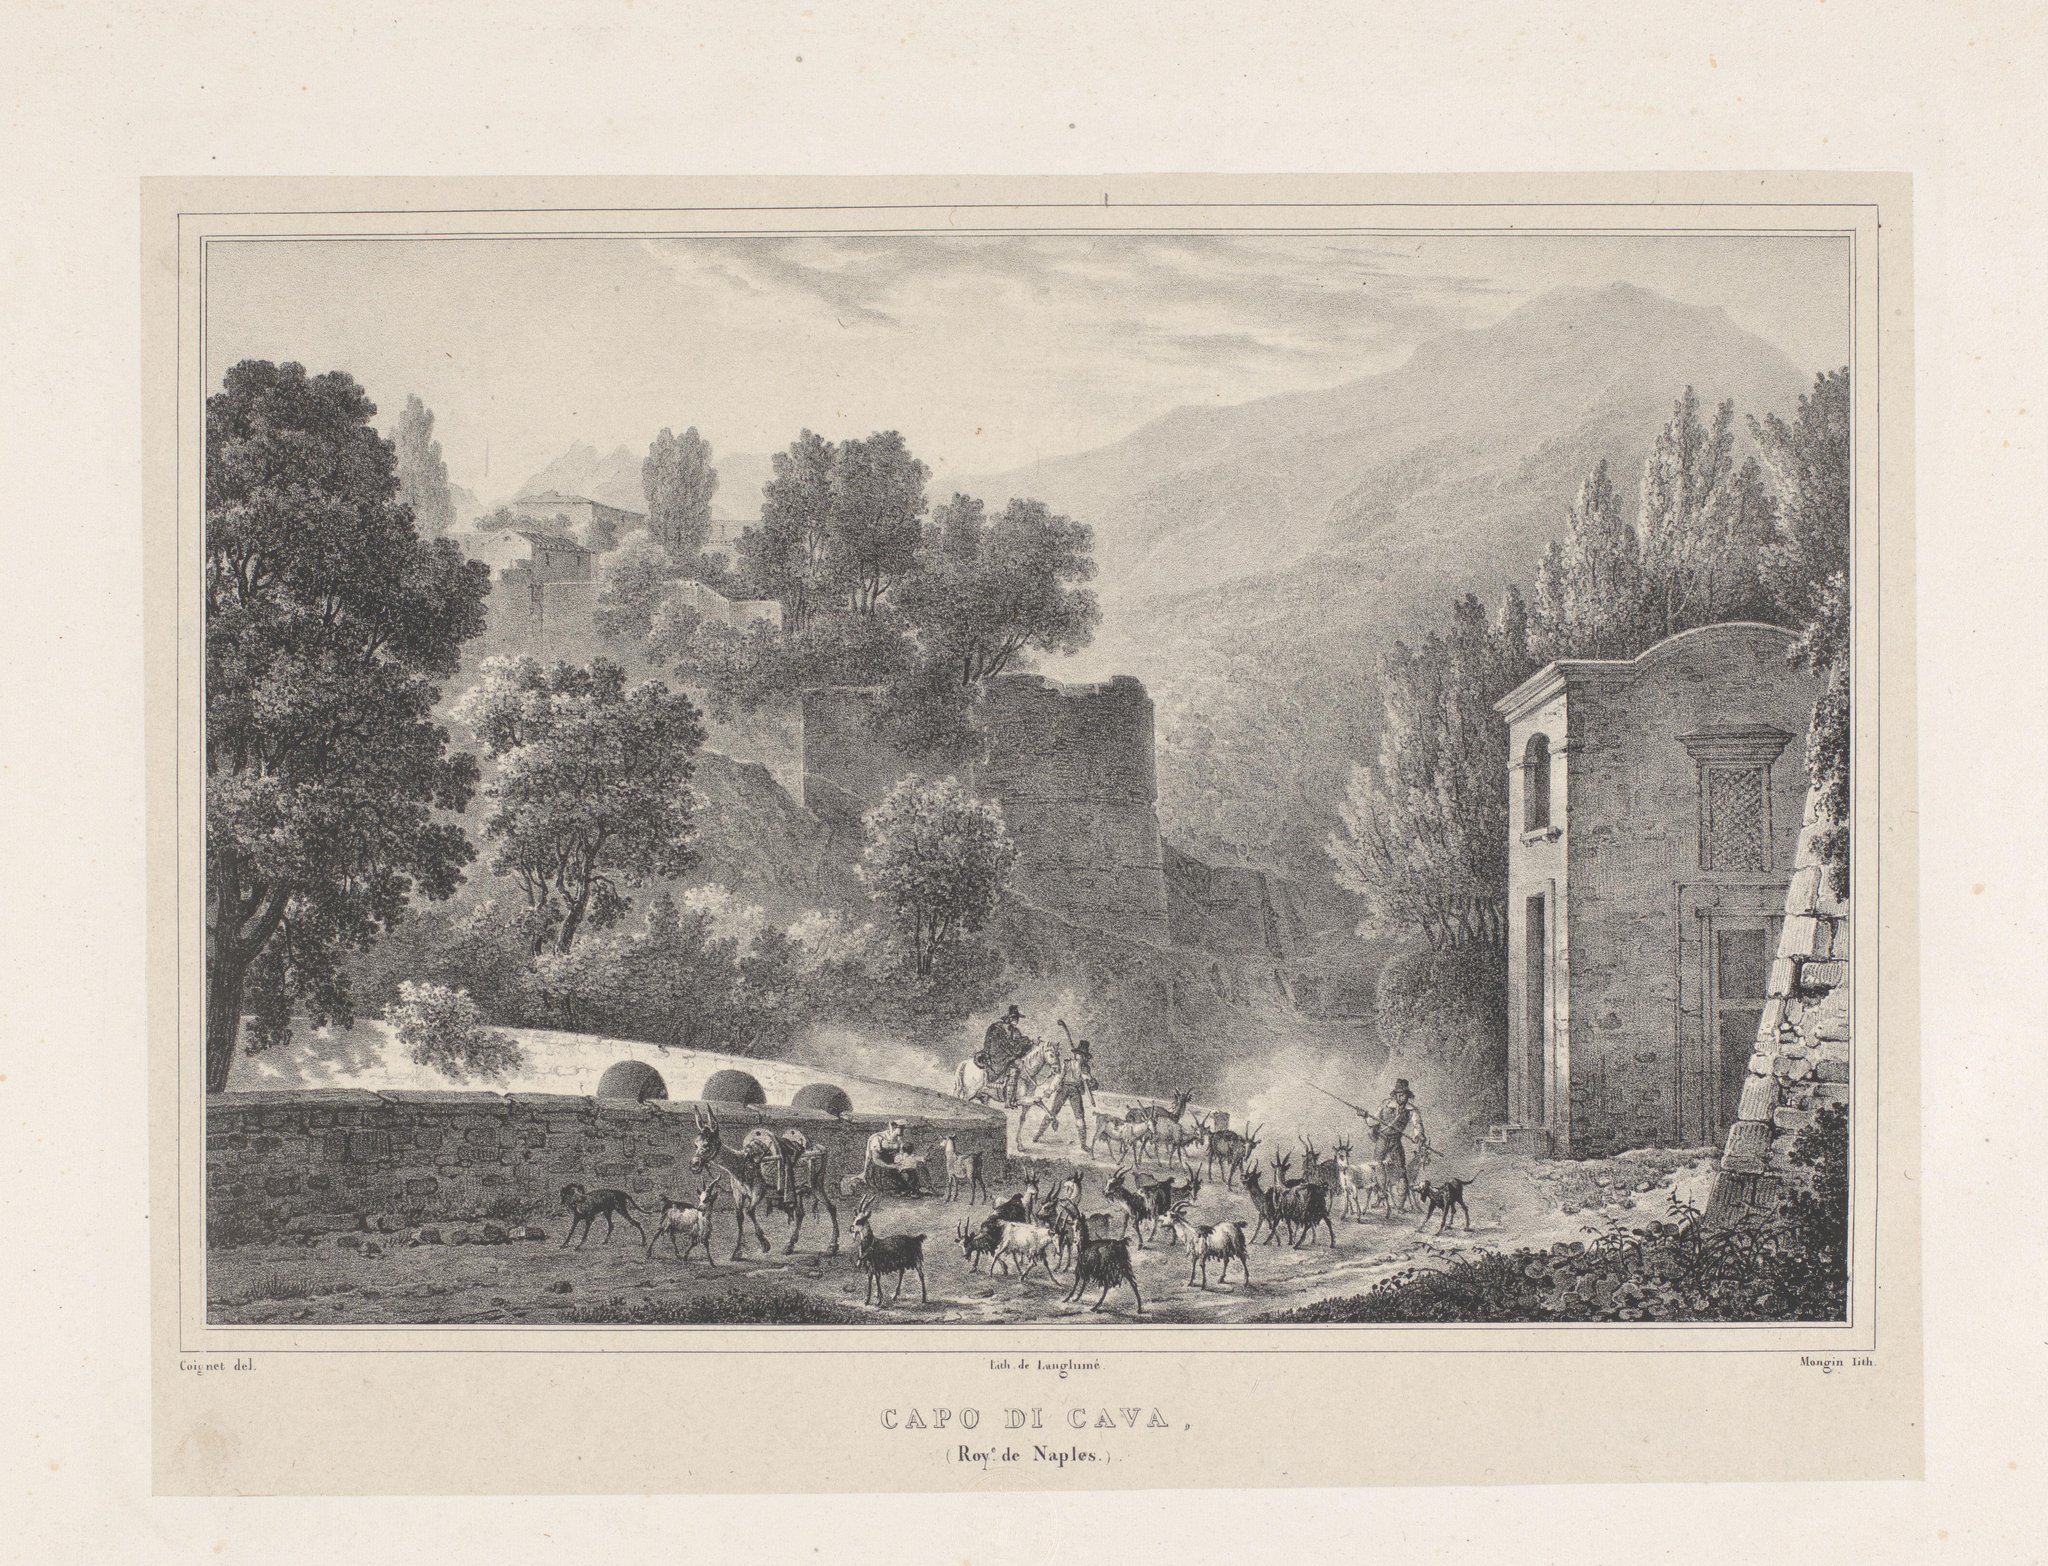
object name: print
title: Gezichten in Italië naar tekeningen van Jules Coignet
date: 1824-1826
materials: paper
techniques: lithograph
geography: paris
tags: herding, herdsman, herdswoman, shepherd, shepherdess, cowherd, etc., landscape with bridge, viaduct or aqueduct, outskirts of village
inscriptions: check stamp: Lugt 3431, collector's mark: Lugt 2228, watermark: ‘Duval’